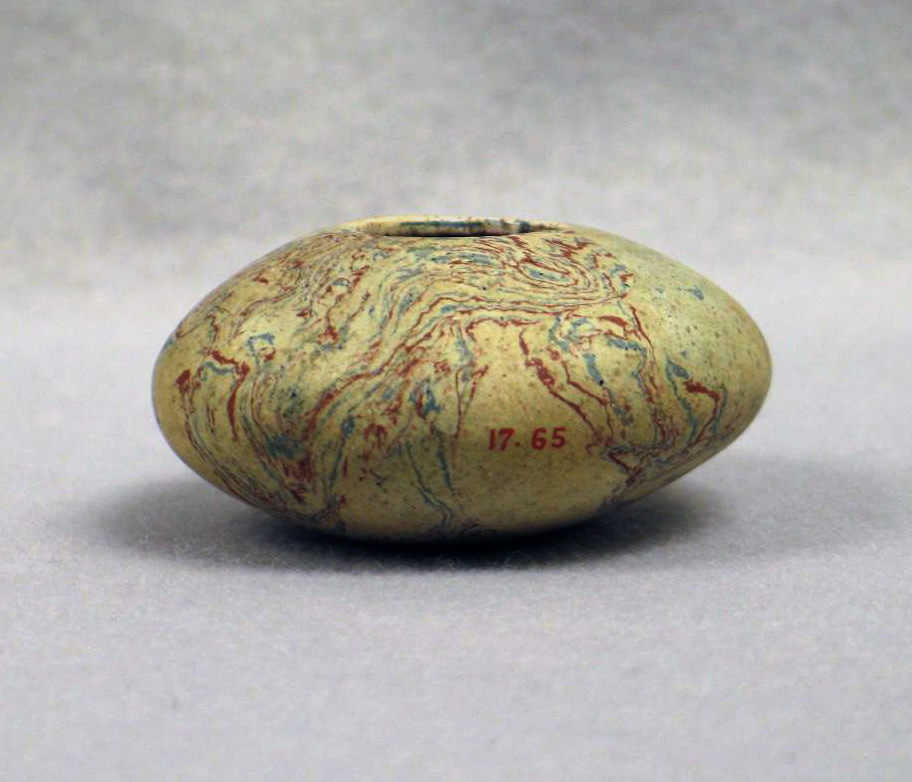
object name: water pot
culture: chinese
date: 1001-1200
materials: clay, marble, stoneware